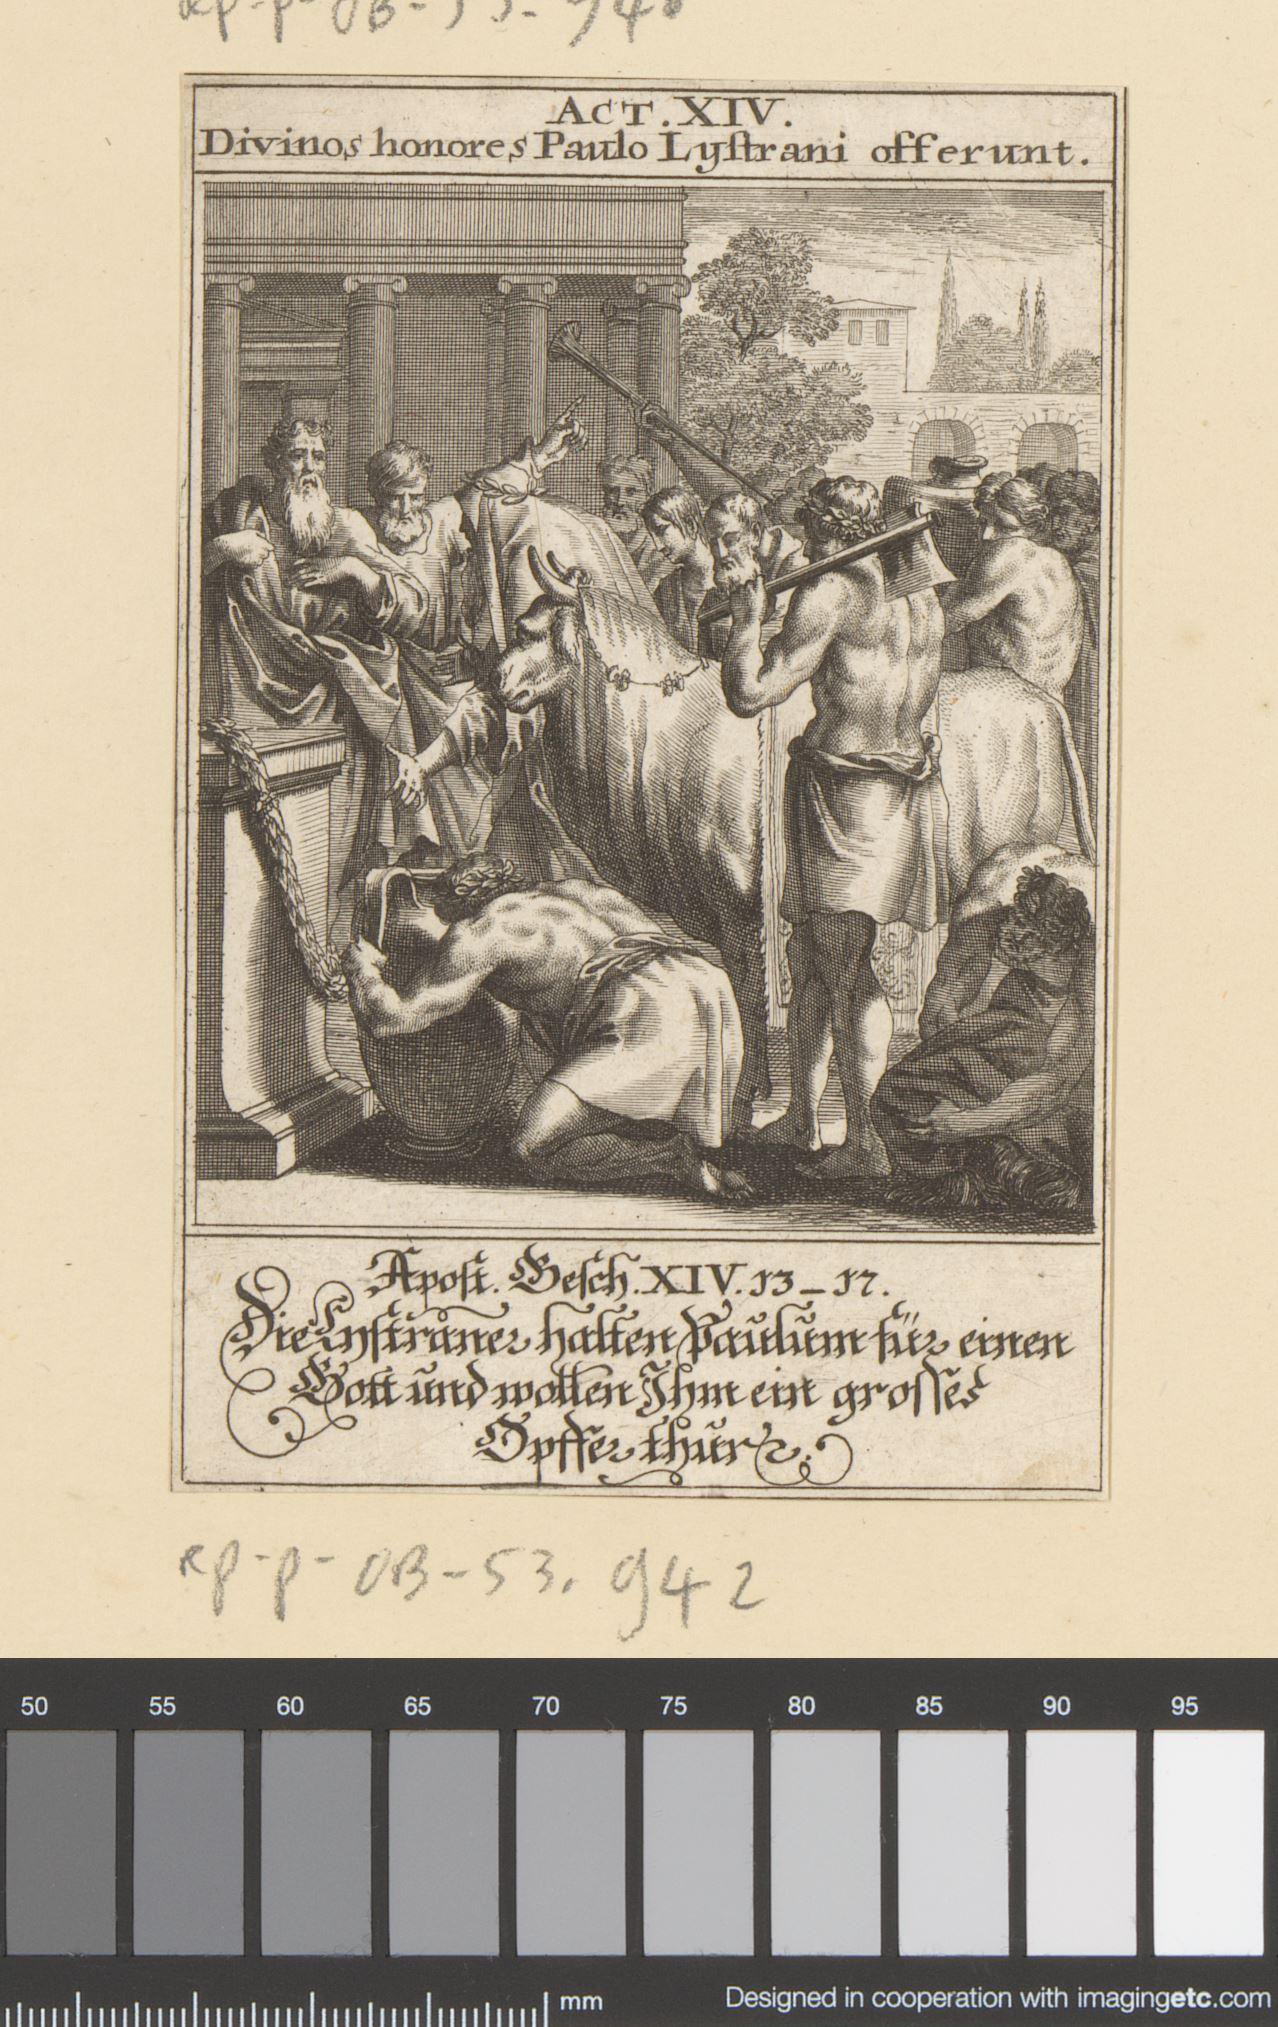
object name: print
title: Bevolking van Lystra bereidt een offerfeest voor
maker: Anonymous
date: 1697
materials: paper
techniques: etching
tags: preparation of the sacrificial celebration with oxen and garlands in front of the temple of jupiter ~ paul and barnabas at lystra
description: Prent ook gebruikt in: Biblia ectypa : Bildnussen auss Heiliger Schrifft. Regensburg: Chr. Wiegel, 1697.